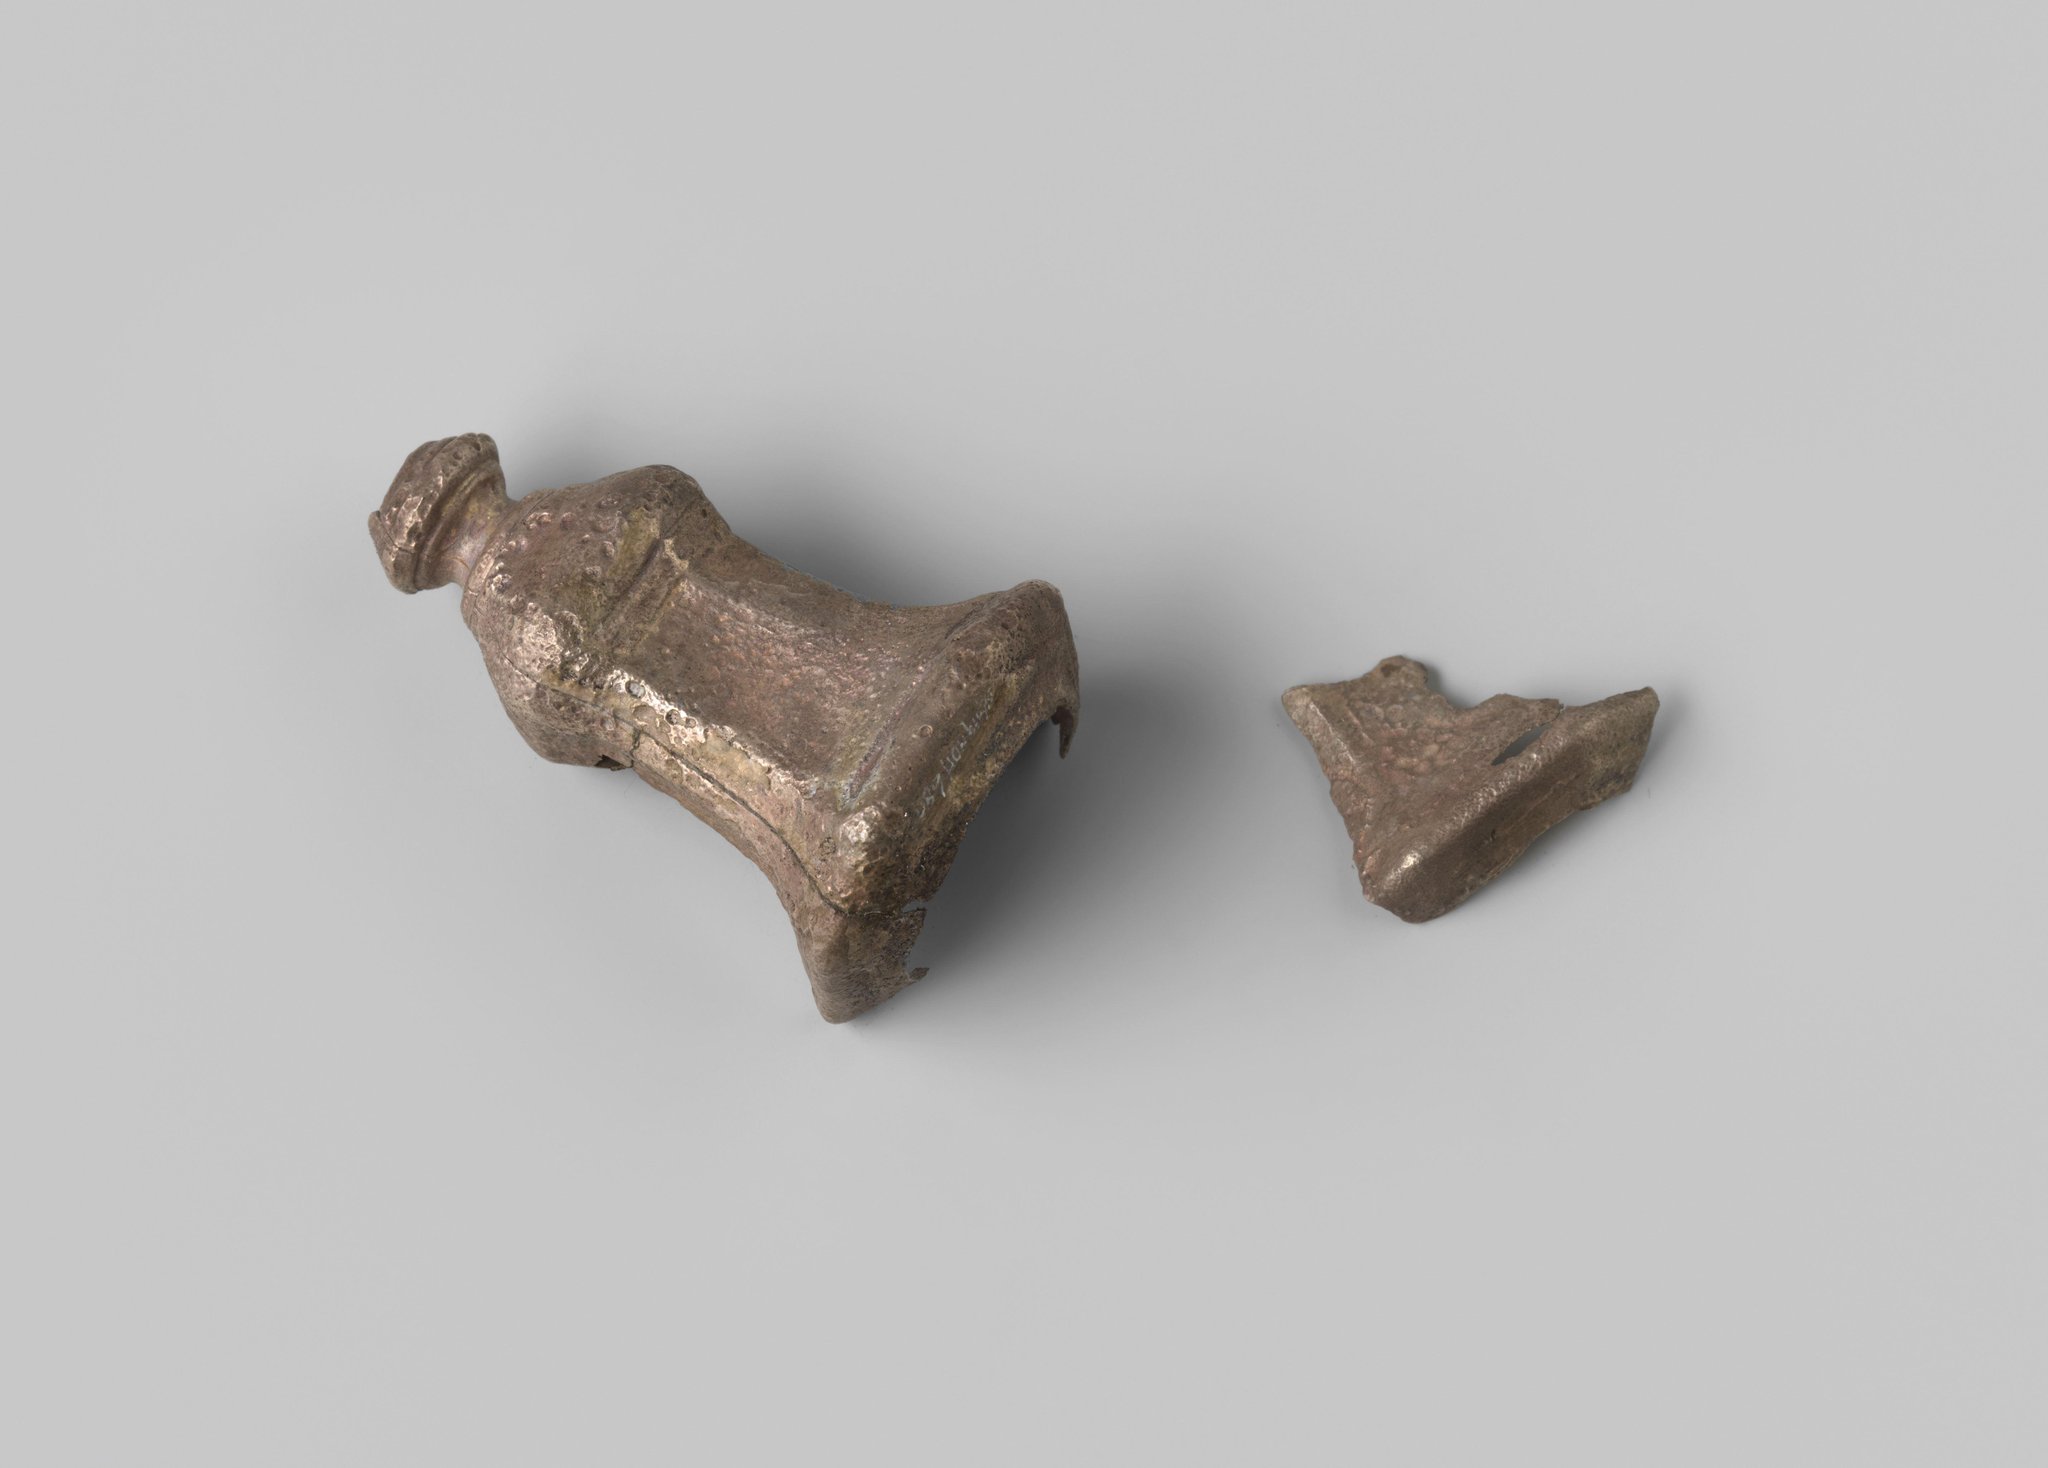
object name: candlestick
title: Fragmenten steel van een kandelaar uit het wrak van de Oost-Indiëvaarder Hollandia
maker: Anonymous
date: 1700-1743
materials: silver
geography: netherlands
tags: verenigde oostindische compagnie, hollandia (schip), annet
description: Candlestick, stem; fragm, socket, hollow, everted, octagonal faceted with 4 long and 4 short sides, spool-shaped element and flattened knop underneath (ass. NG 1980-27H2873).